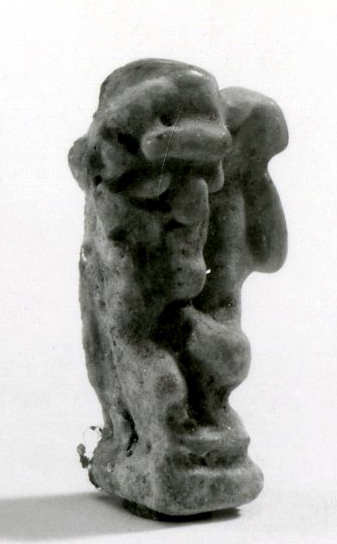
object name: amulet, shu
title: Shu Amulet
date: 664-332 BCE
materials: faience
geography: egypt